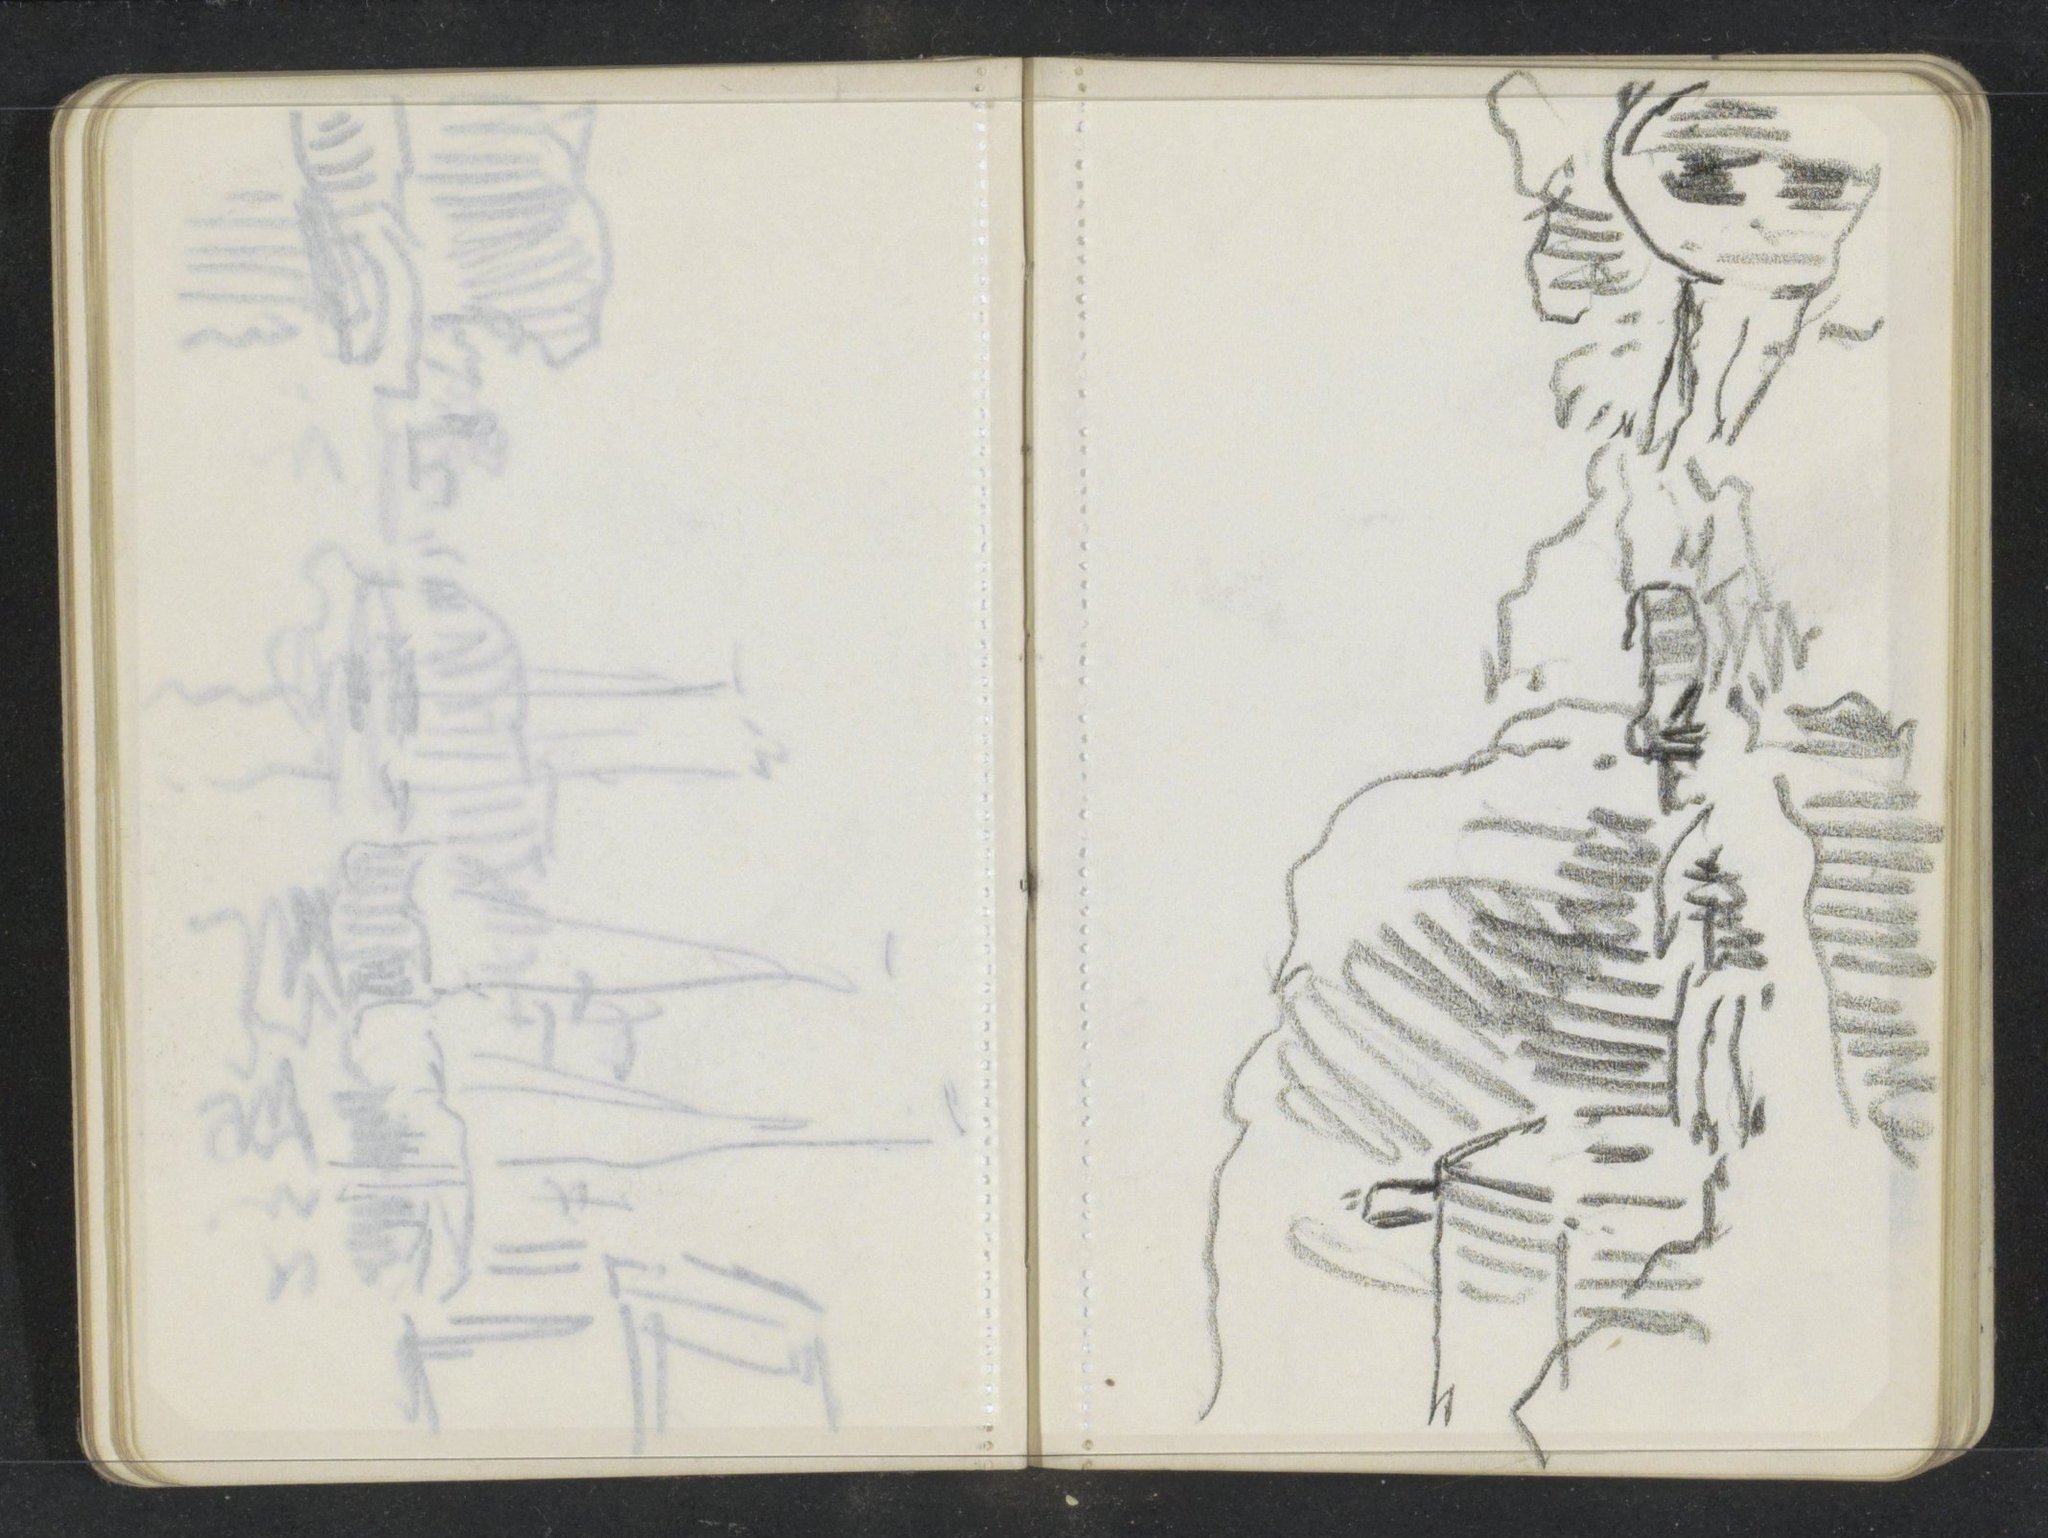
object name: sketchbook leaf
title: Huis aan een waterkant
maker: alexander shilling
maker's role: draughtsman, print maker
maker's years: 1859-1937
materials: chalk, paper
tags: landscapes with waters, waterscapes, seascapes (in the temperate zone), cottage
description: Blad 30 recto uit een schetsboek met 91 bladen.